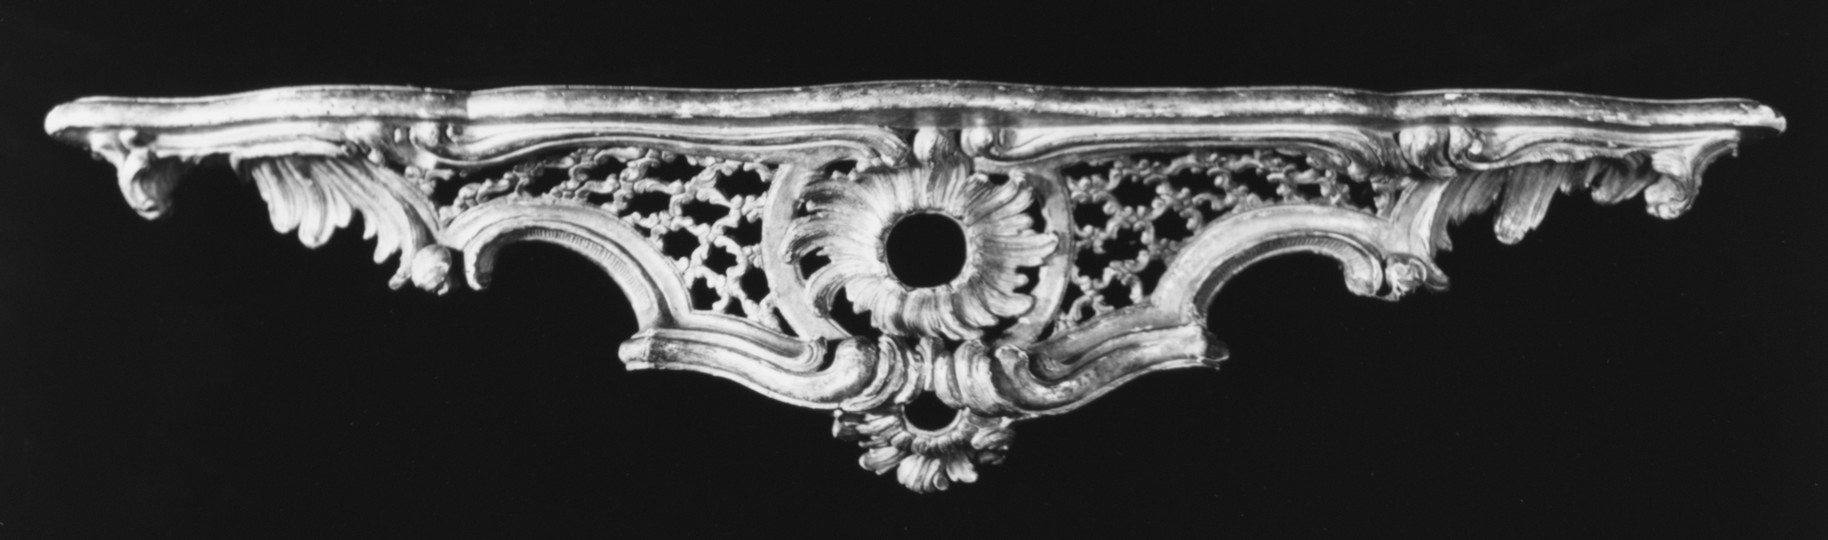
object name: bracket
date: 1750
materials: wood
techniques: carving, gilding